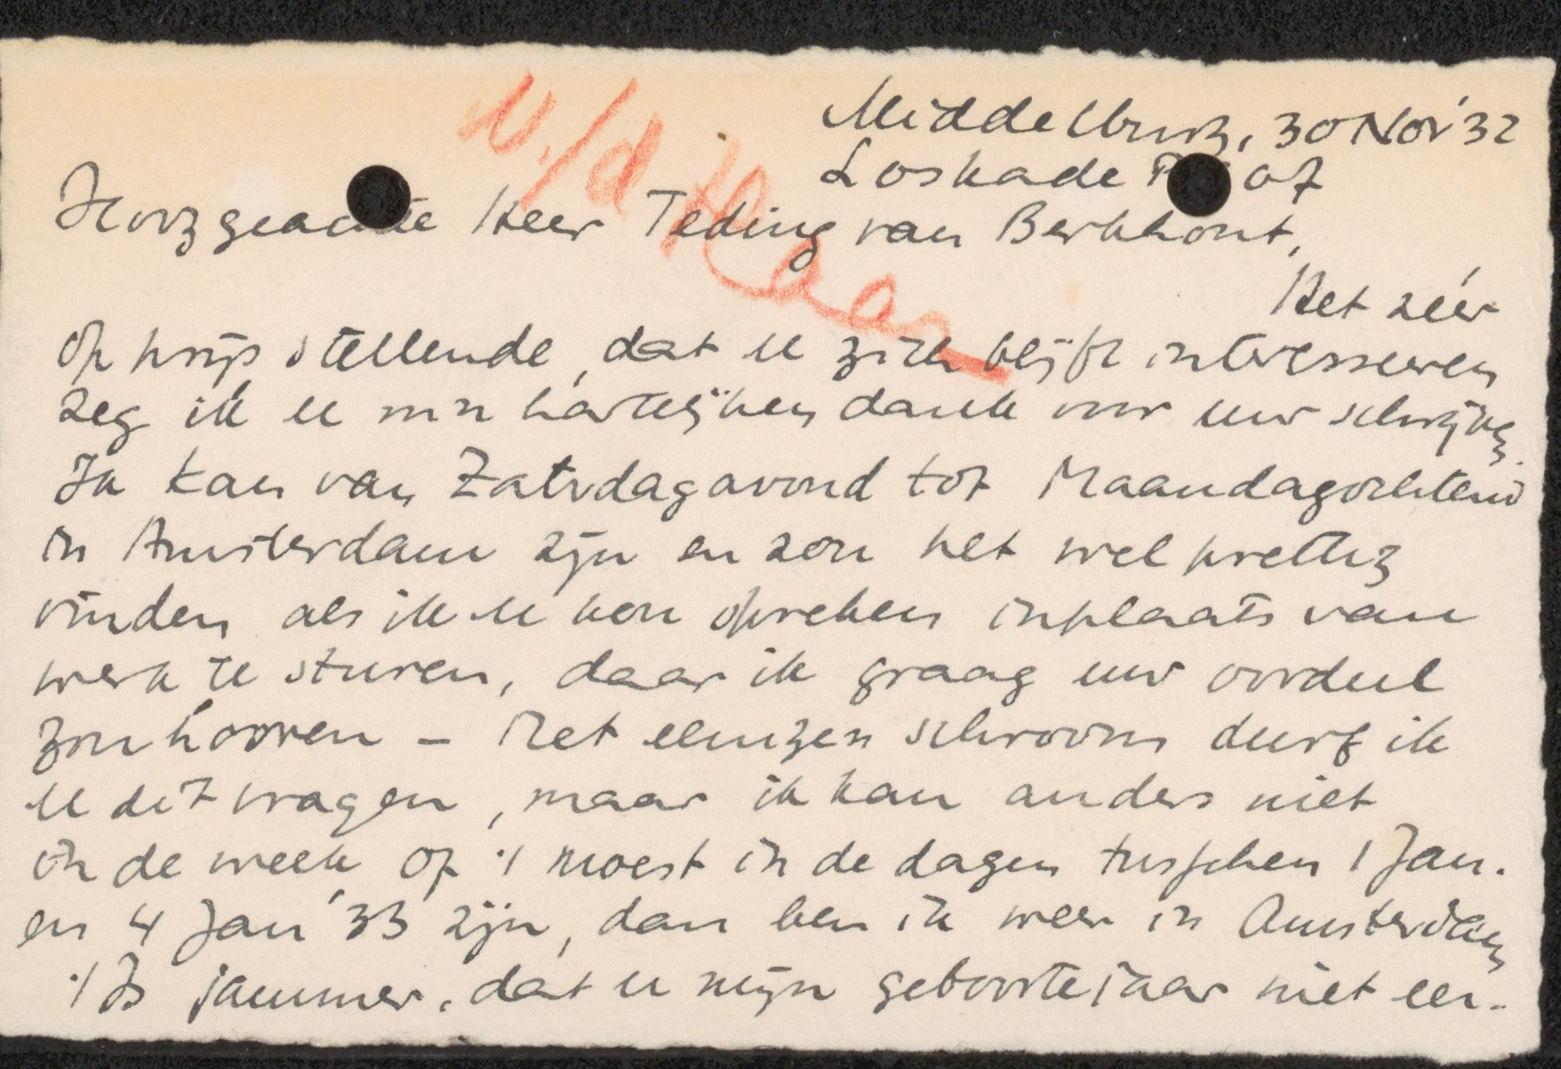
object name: letter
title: Brief aan jonkheer Hendrik Teding van Berkhout (1879-1969)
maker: dolf van der haar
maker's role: draughtsman, print maker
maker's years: 1899-1973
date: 1932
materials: cardboard, ink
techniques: pen, writing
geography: middelburg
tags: amsterdam, jonkheer hendrik teding van berkhout (1879-1969), art collecting